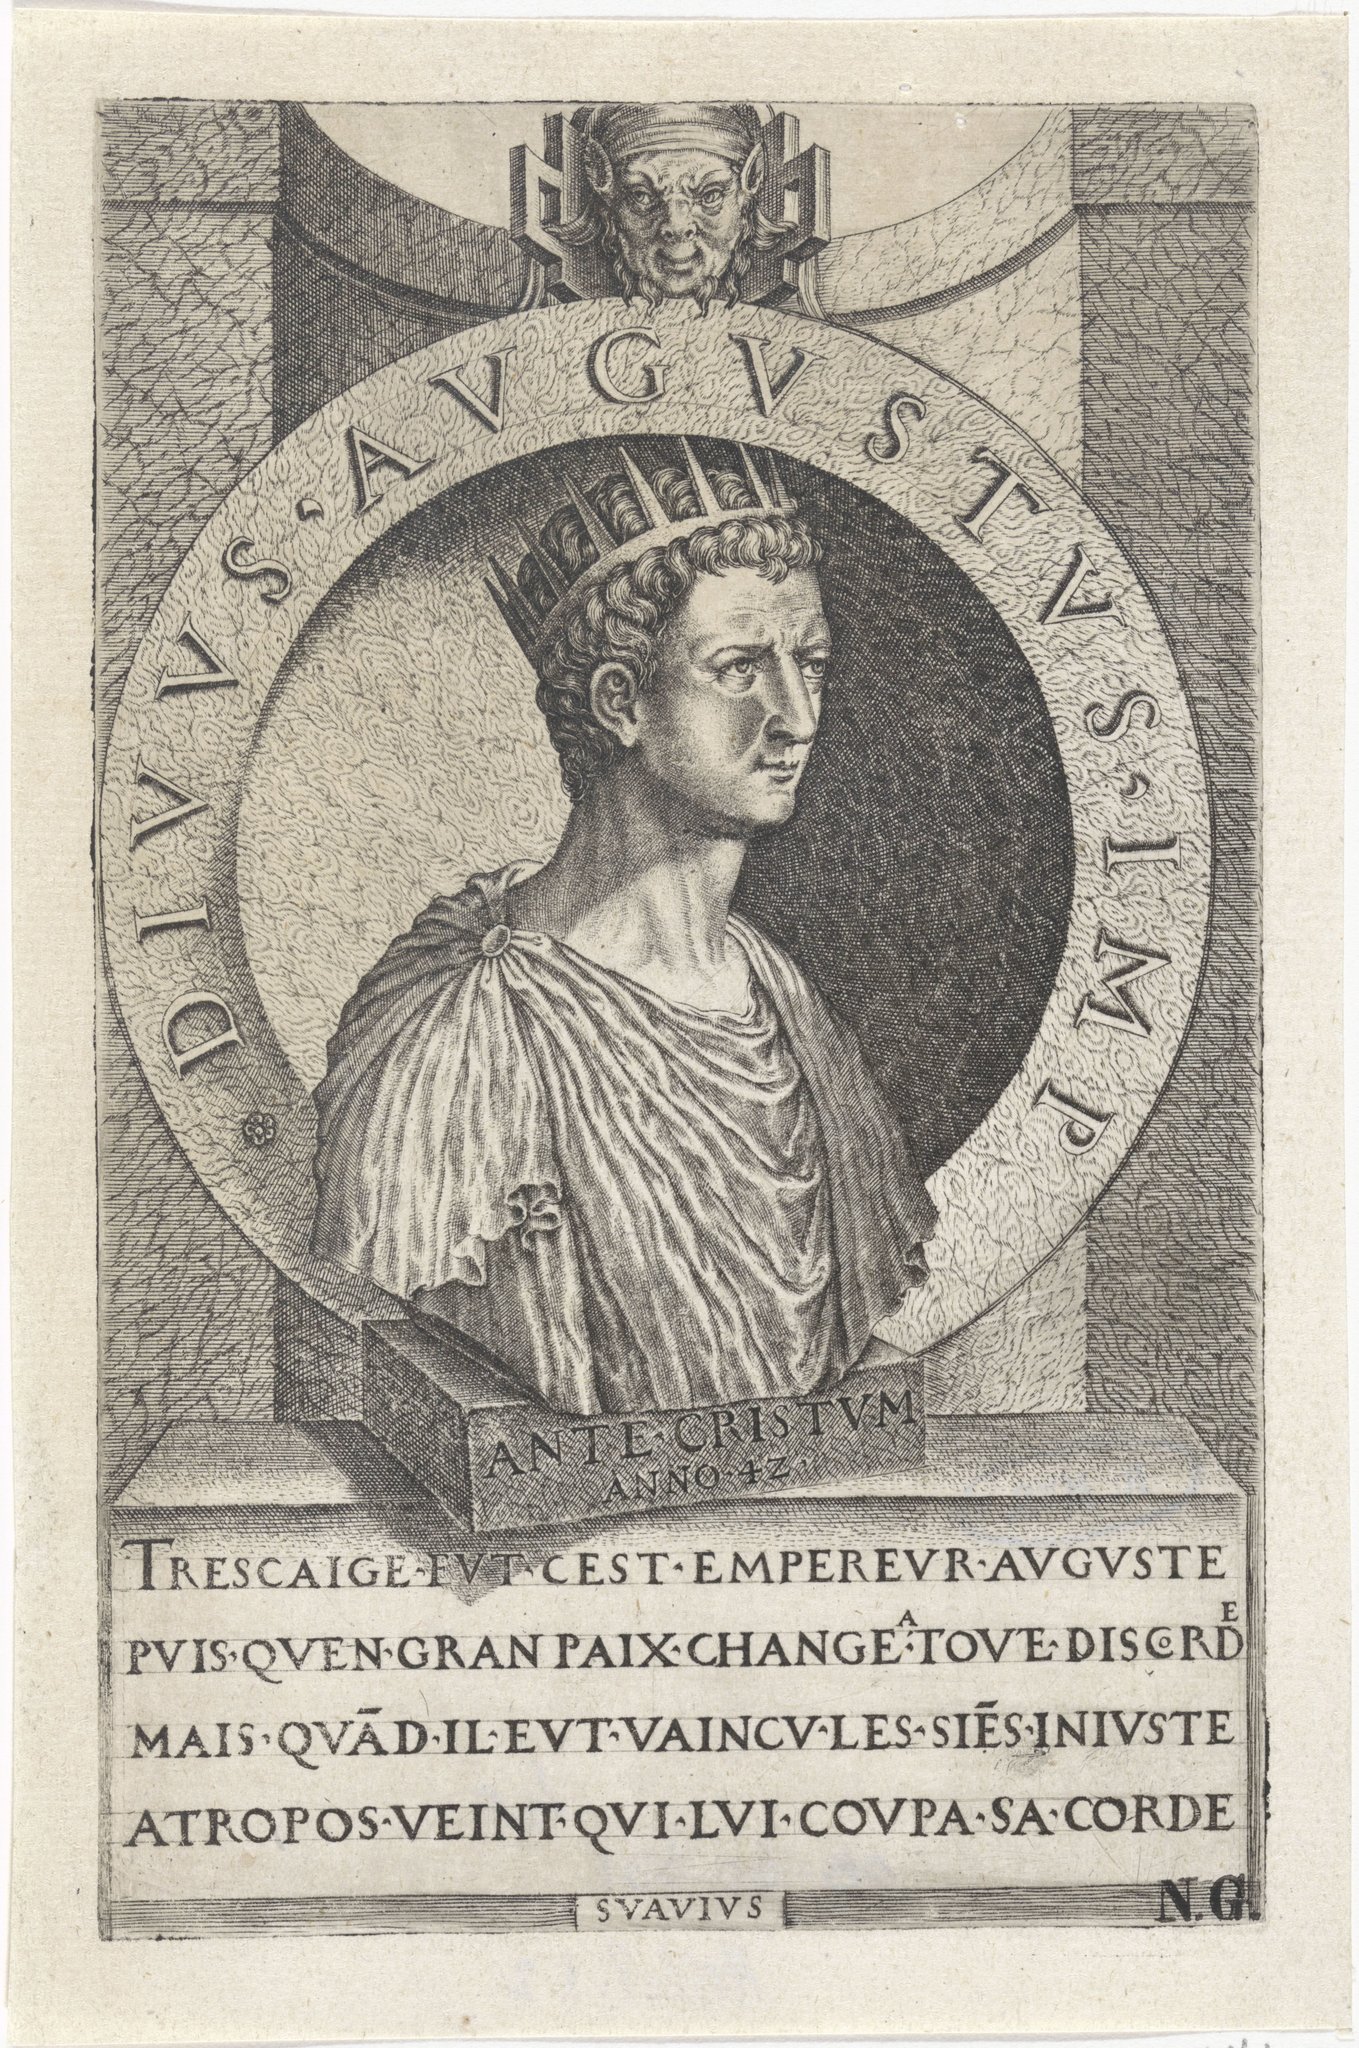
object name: print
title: Romeinse keizers en keizerinnen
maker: lambertus suavius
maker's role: print maker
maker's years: 1514-1564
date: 1520-1567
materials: paper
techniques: engraving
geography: southern netherlands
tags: portrait of augustus, emperor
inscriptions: collector's mark: Lugt 1967, collector's mark: Lugt 2228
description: Buste van keizer Augustus van het Romeinse Rijk, voor een nis. Midden boven een masker. Onderaan een vierregelige tekst in het Frans.